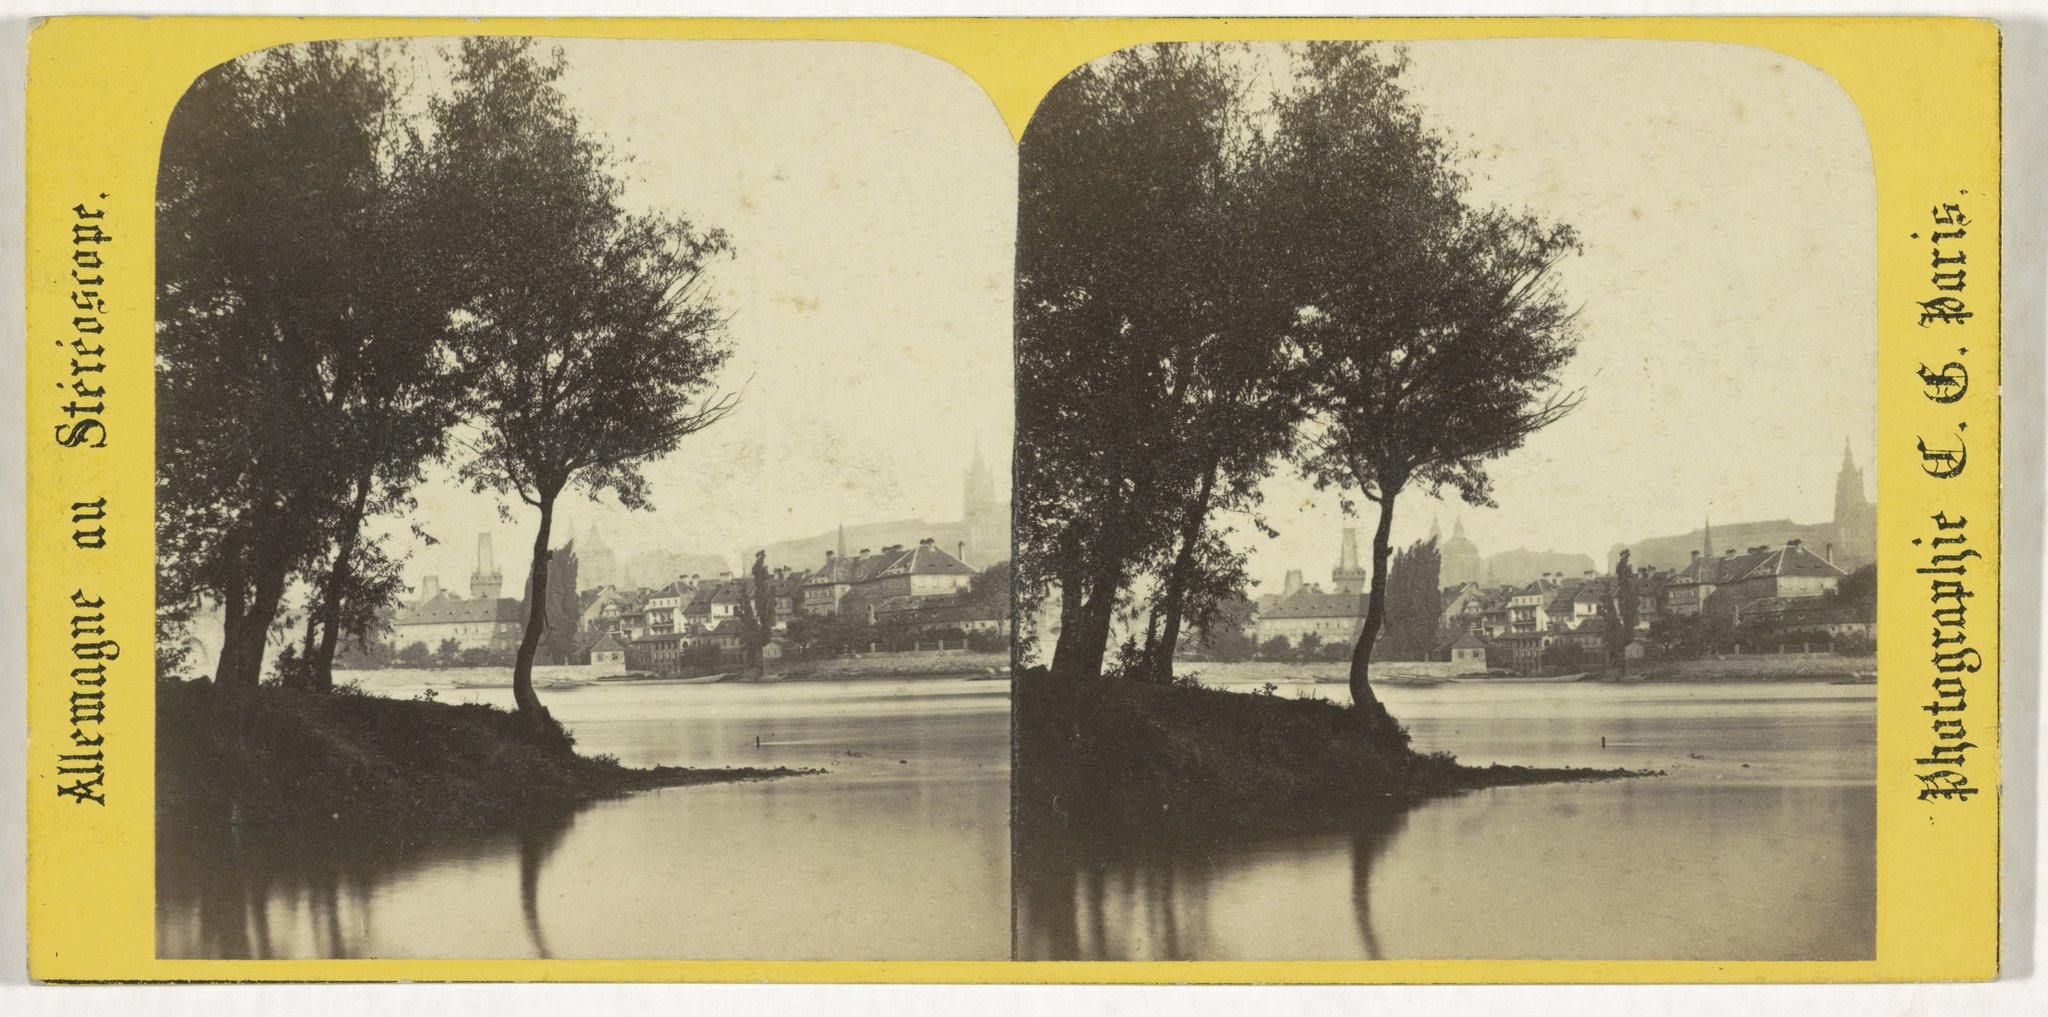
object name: stereograph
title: Gezicht op Praag vanaf de oever van de Moldau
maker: charles gaudin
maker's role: publisher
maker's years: 1825-1905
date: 1868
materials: cardboard, paper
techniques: albumen print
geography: prague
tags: city-view in general; 'veduta', river bank, prague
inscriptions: number: ‘50’, number: ‘184’, number: ‘184’